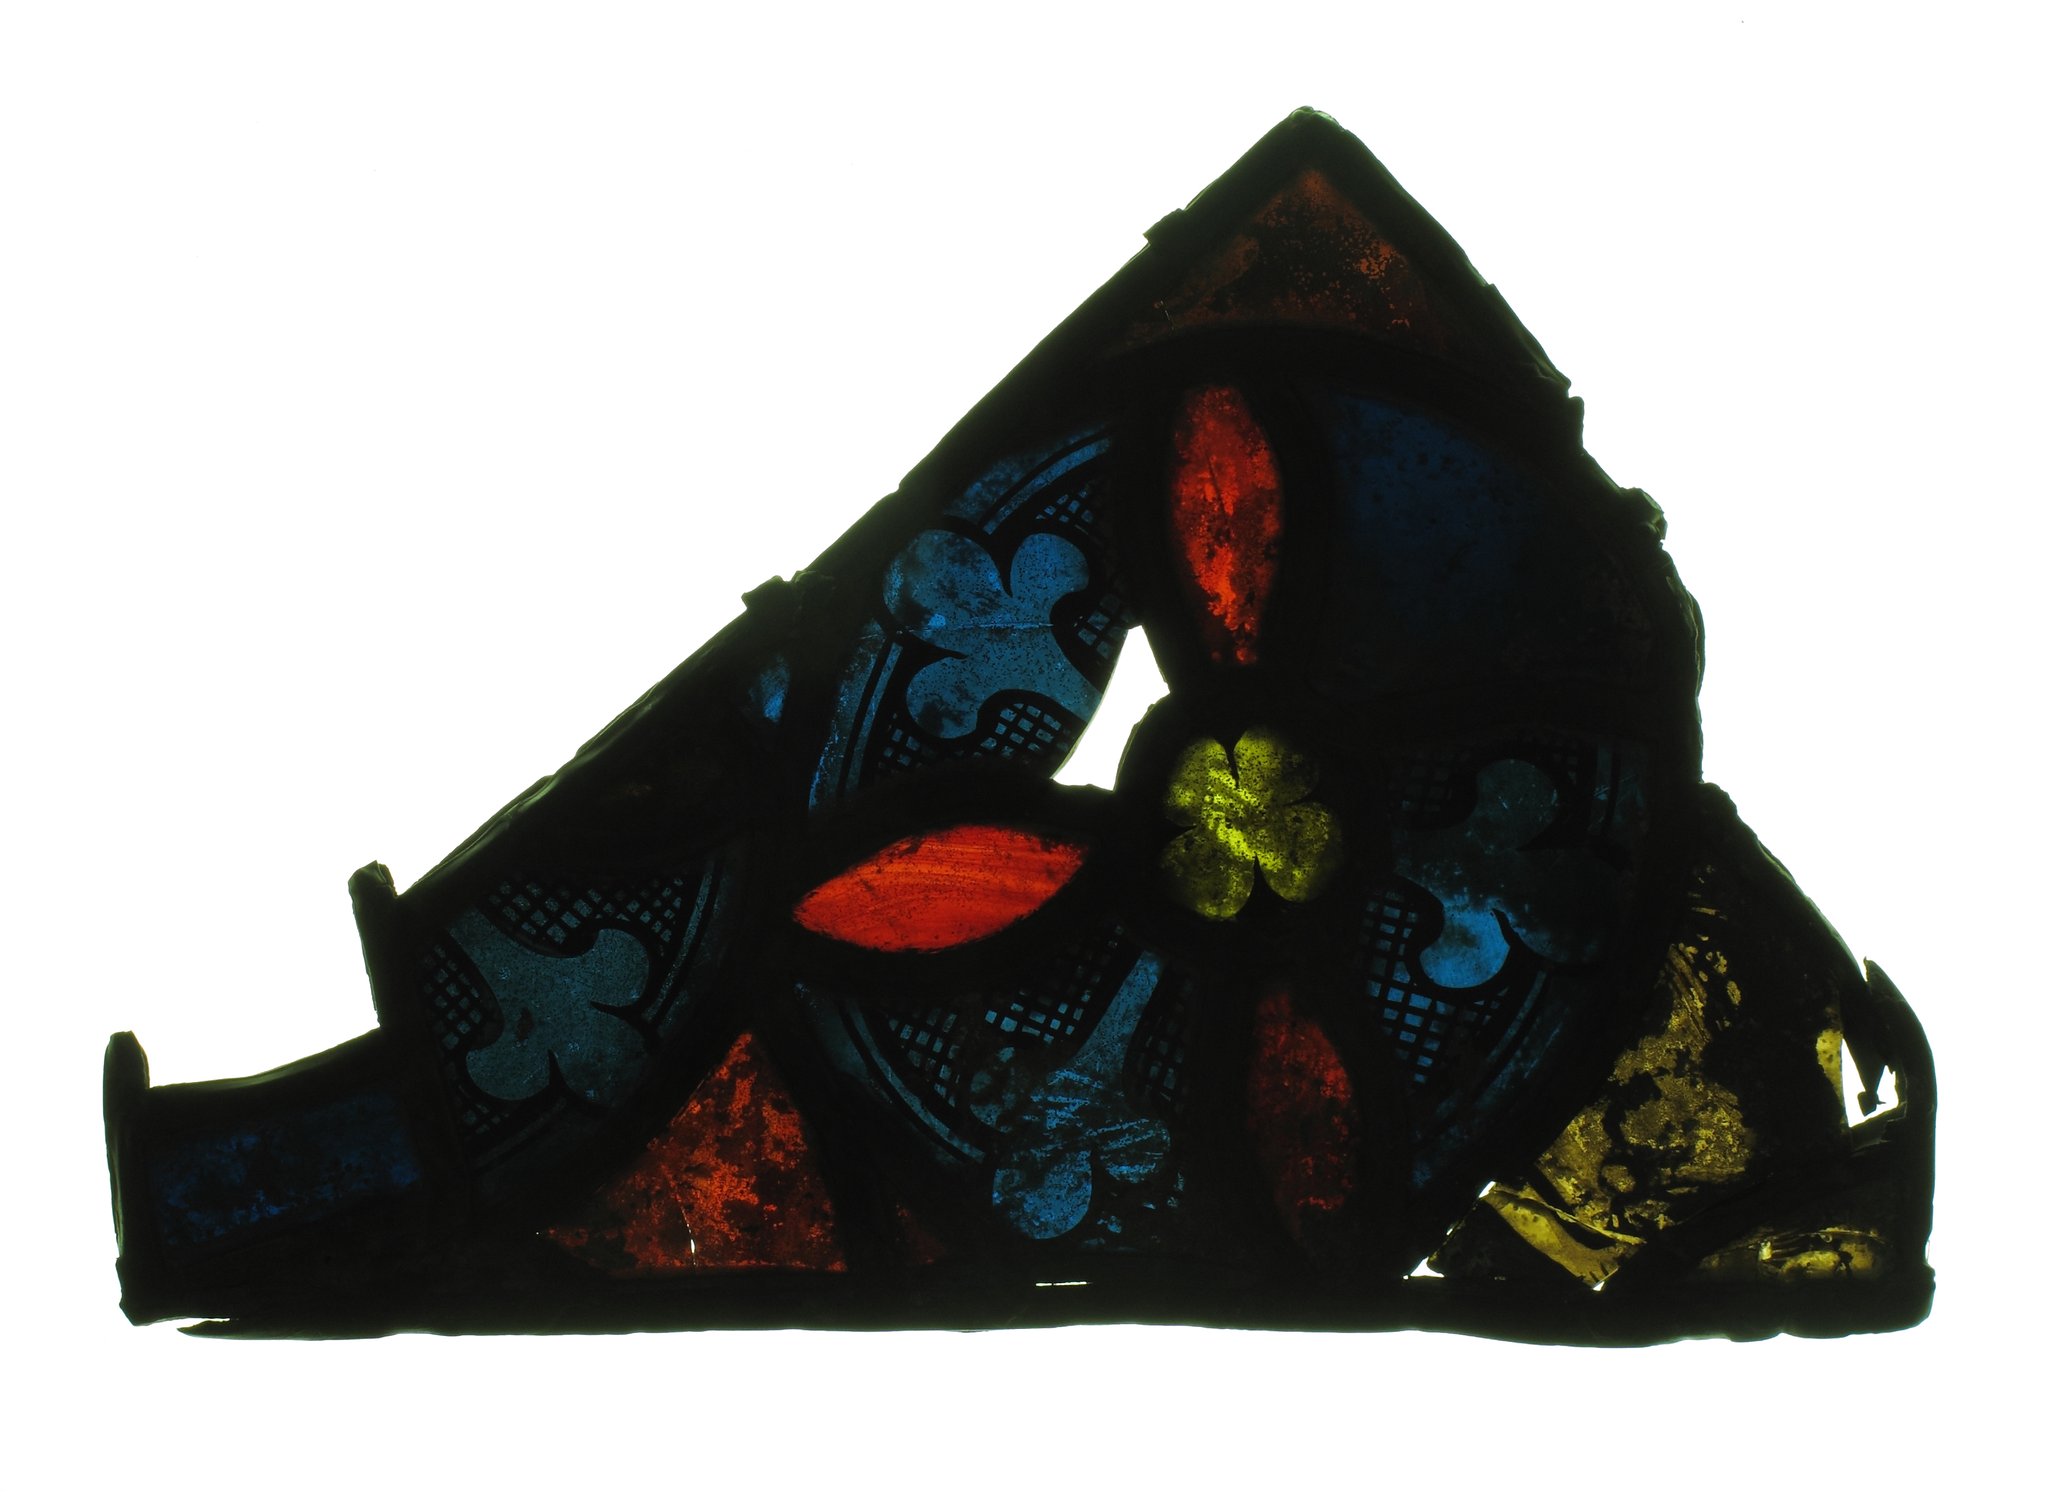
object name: fragment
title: Glass Fragment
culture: european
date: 1201-1300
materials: glass, paint, pigment